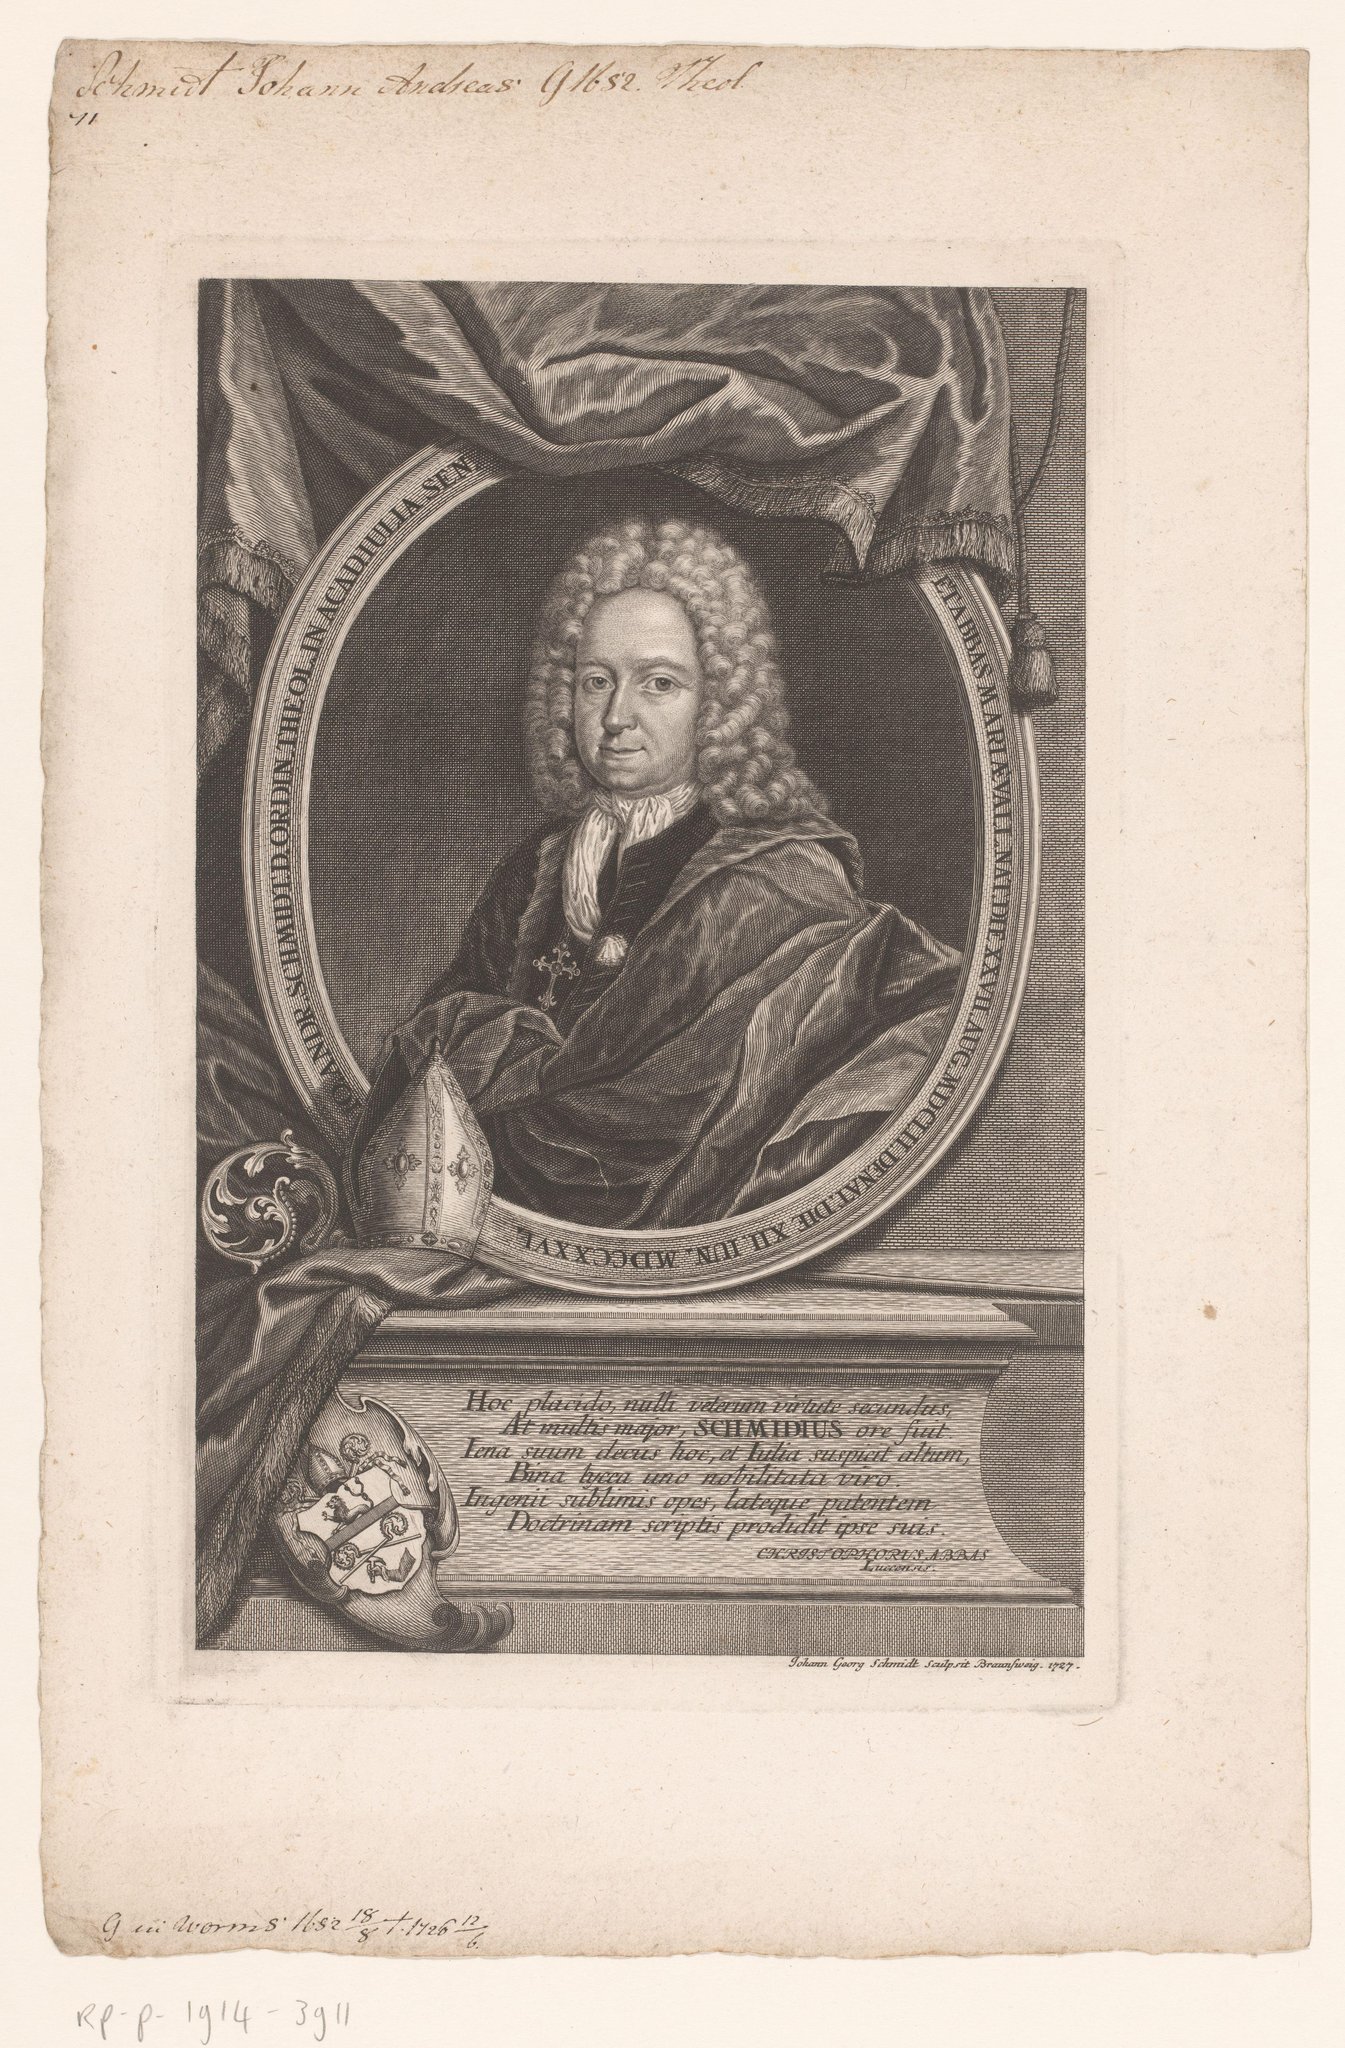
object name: print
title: Portret van Johann Andreas Schmidt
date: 1727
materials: paper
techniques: engraving, etching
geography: braunschweig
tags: johann andreas schmidt, historical persons, armorial bearing, heraldry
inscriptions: collector's mark: Lugt 2228